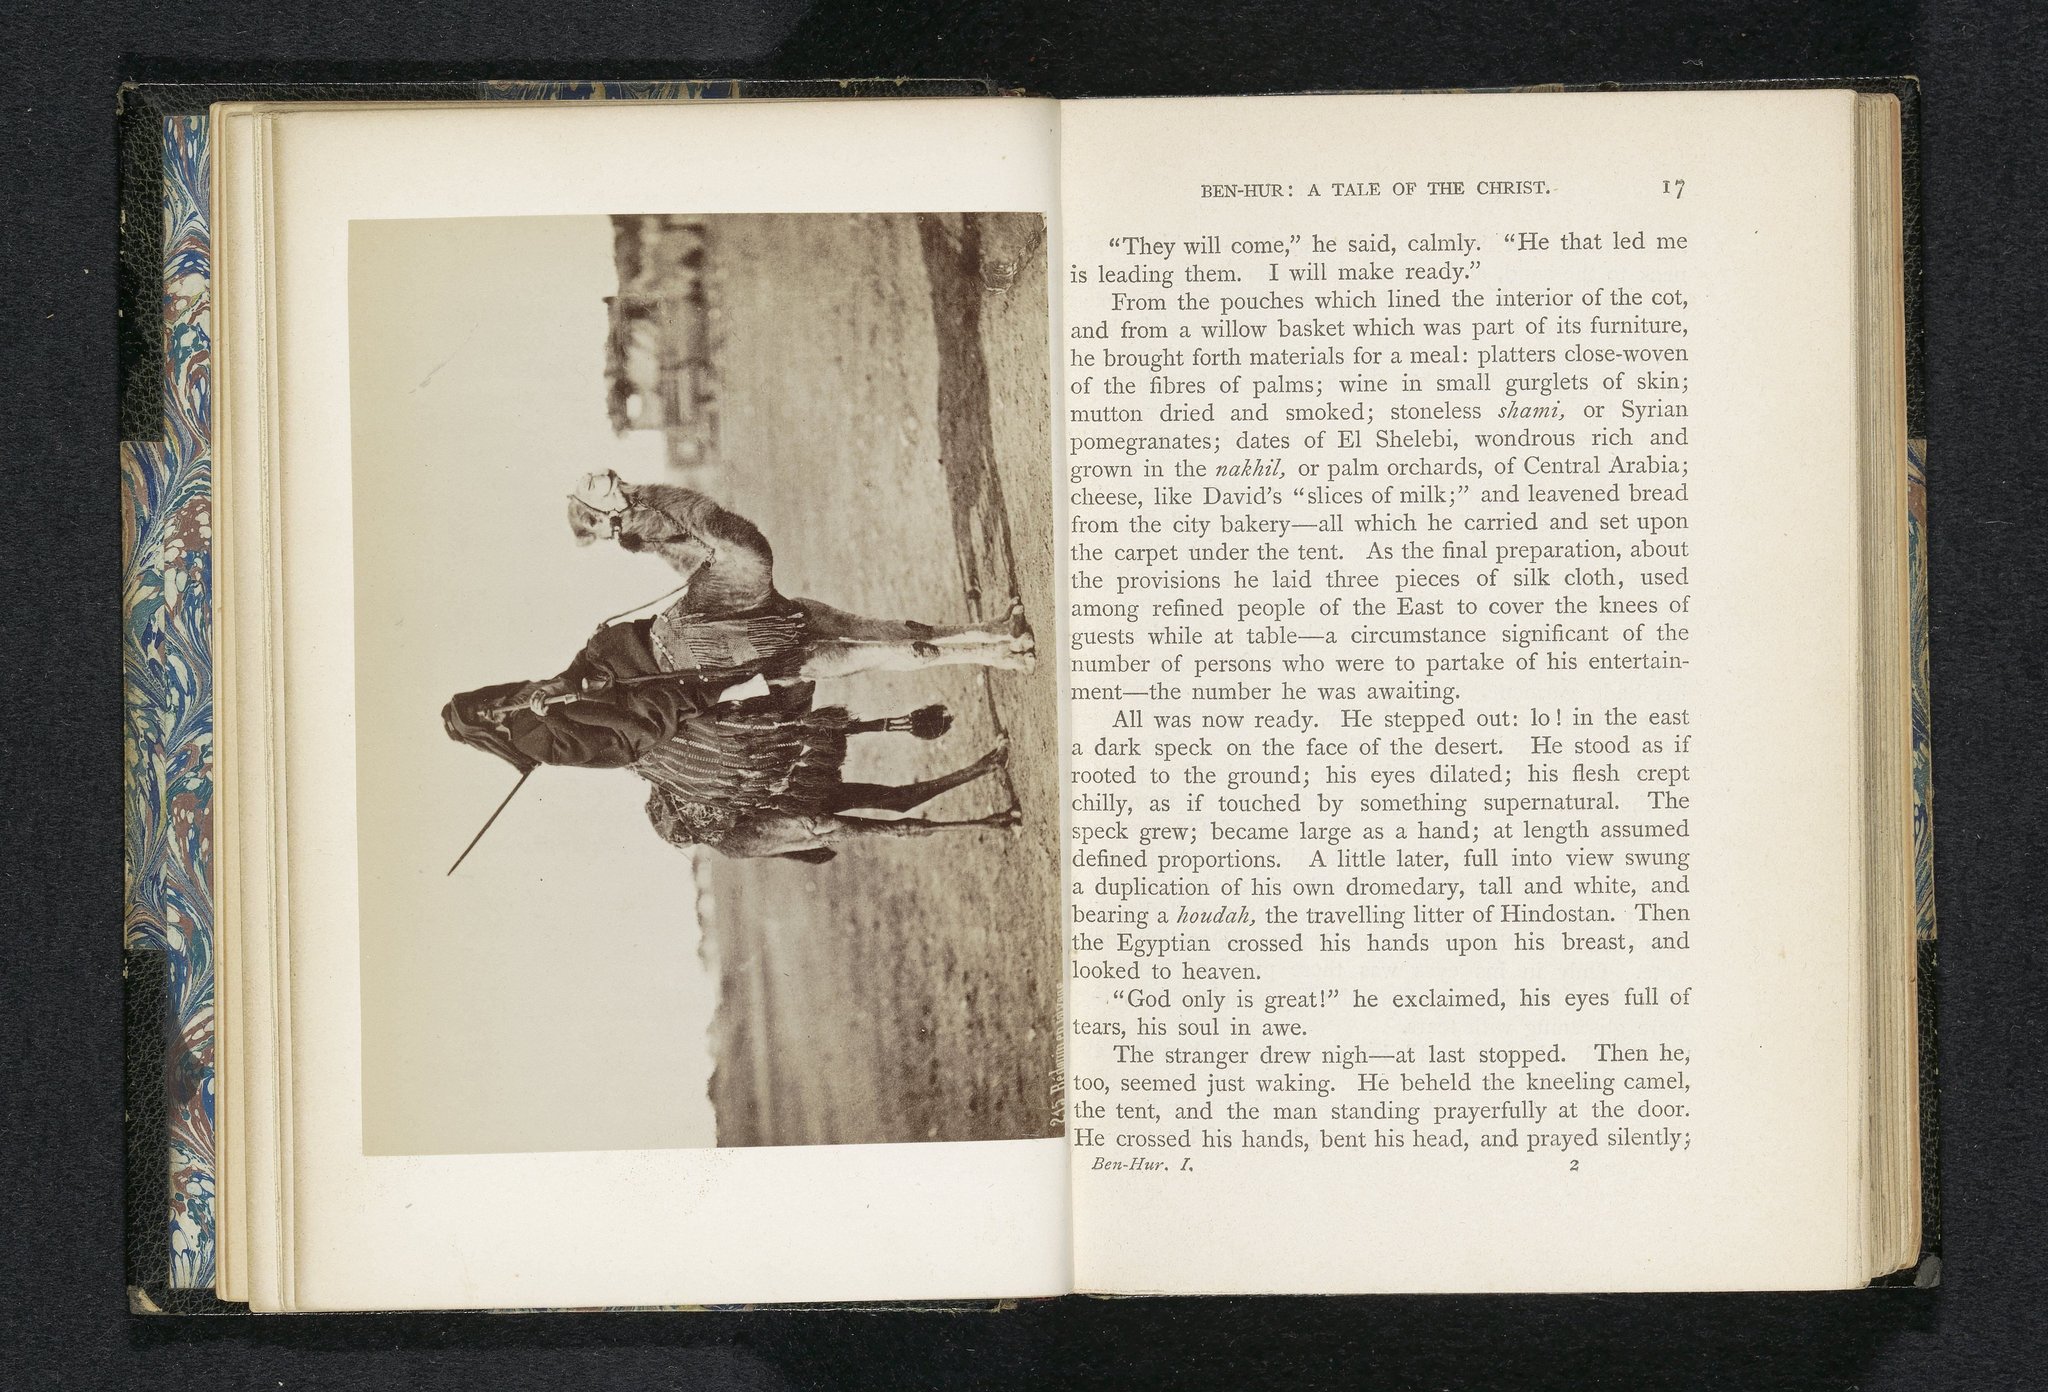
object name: page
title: Bédouin en voyage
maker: Anonymous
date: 1883-1888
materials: photographic support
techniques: albumen print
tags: hoofed animals: camel, wandering communities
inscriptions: number: ‘245’